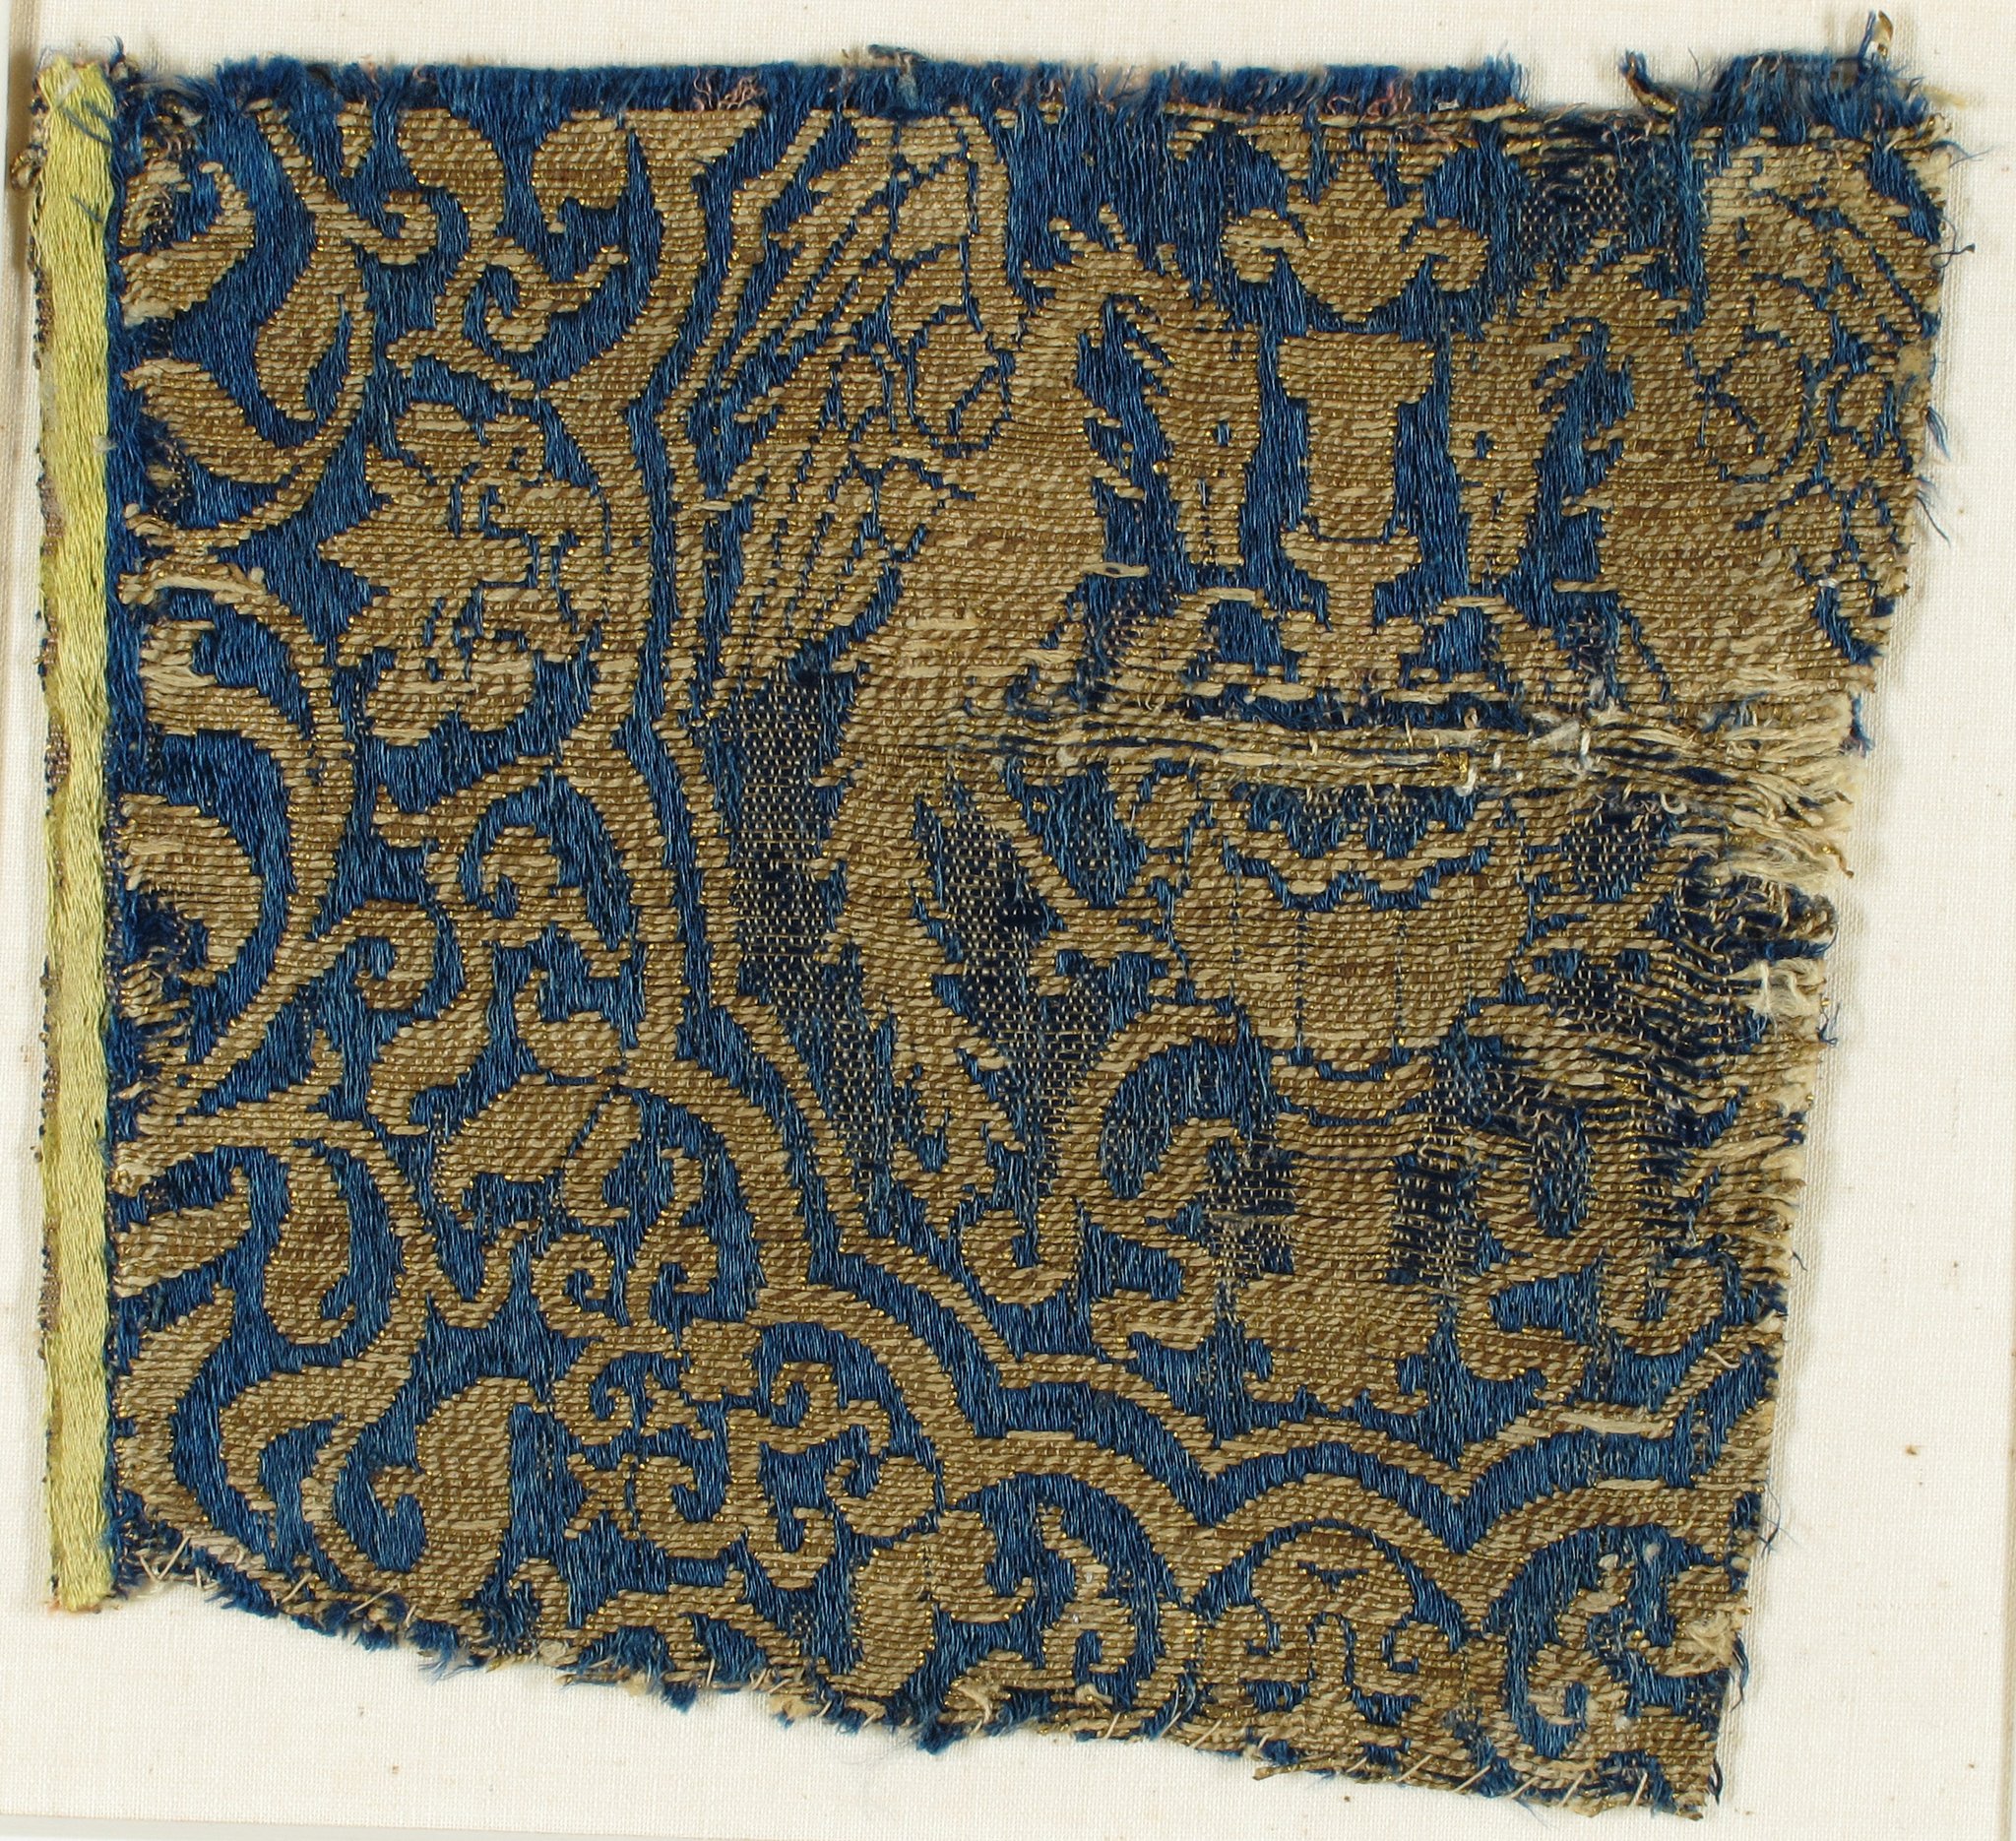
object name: textile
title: Textile with Birds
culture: spanish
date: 1301-1400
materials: metal thread, silk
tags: birds